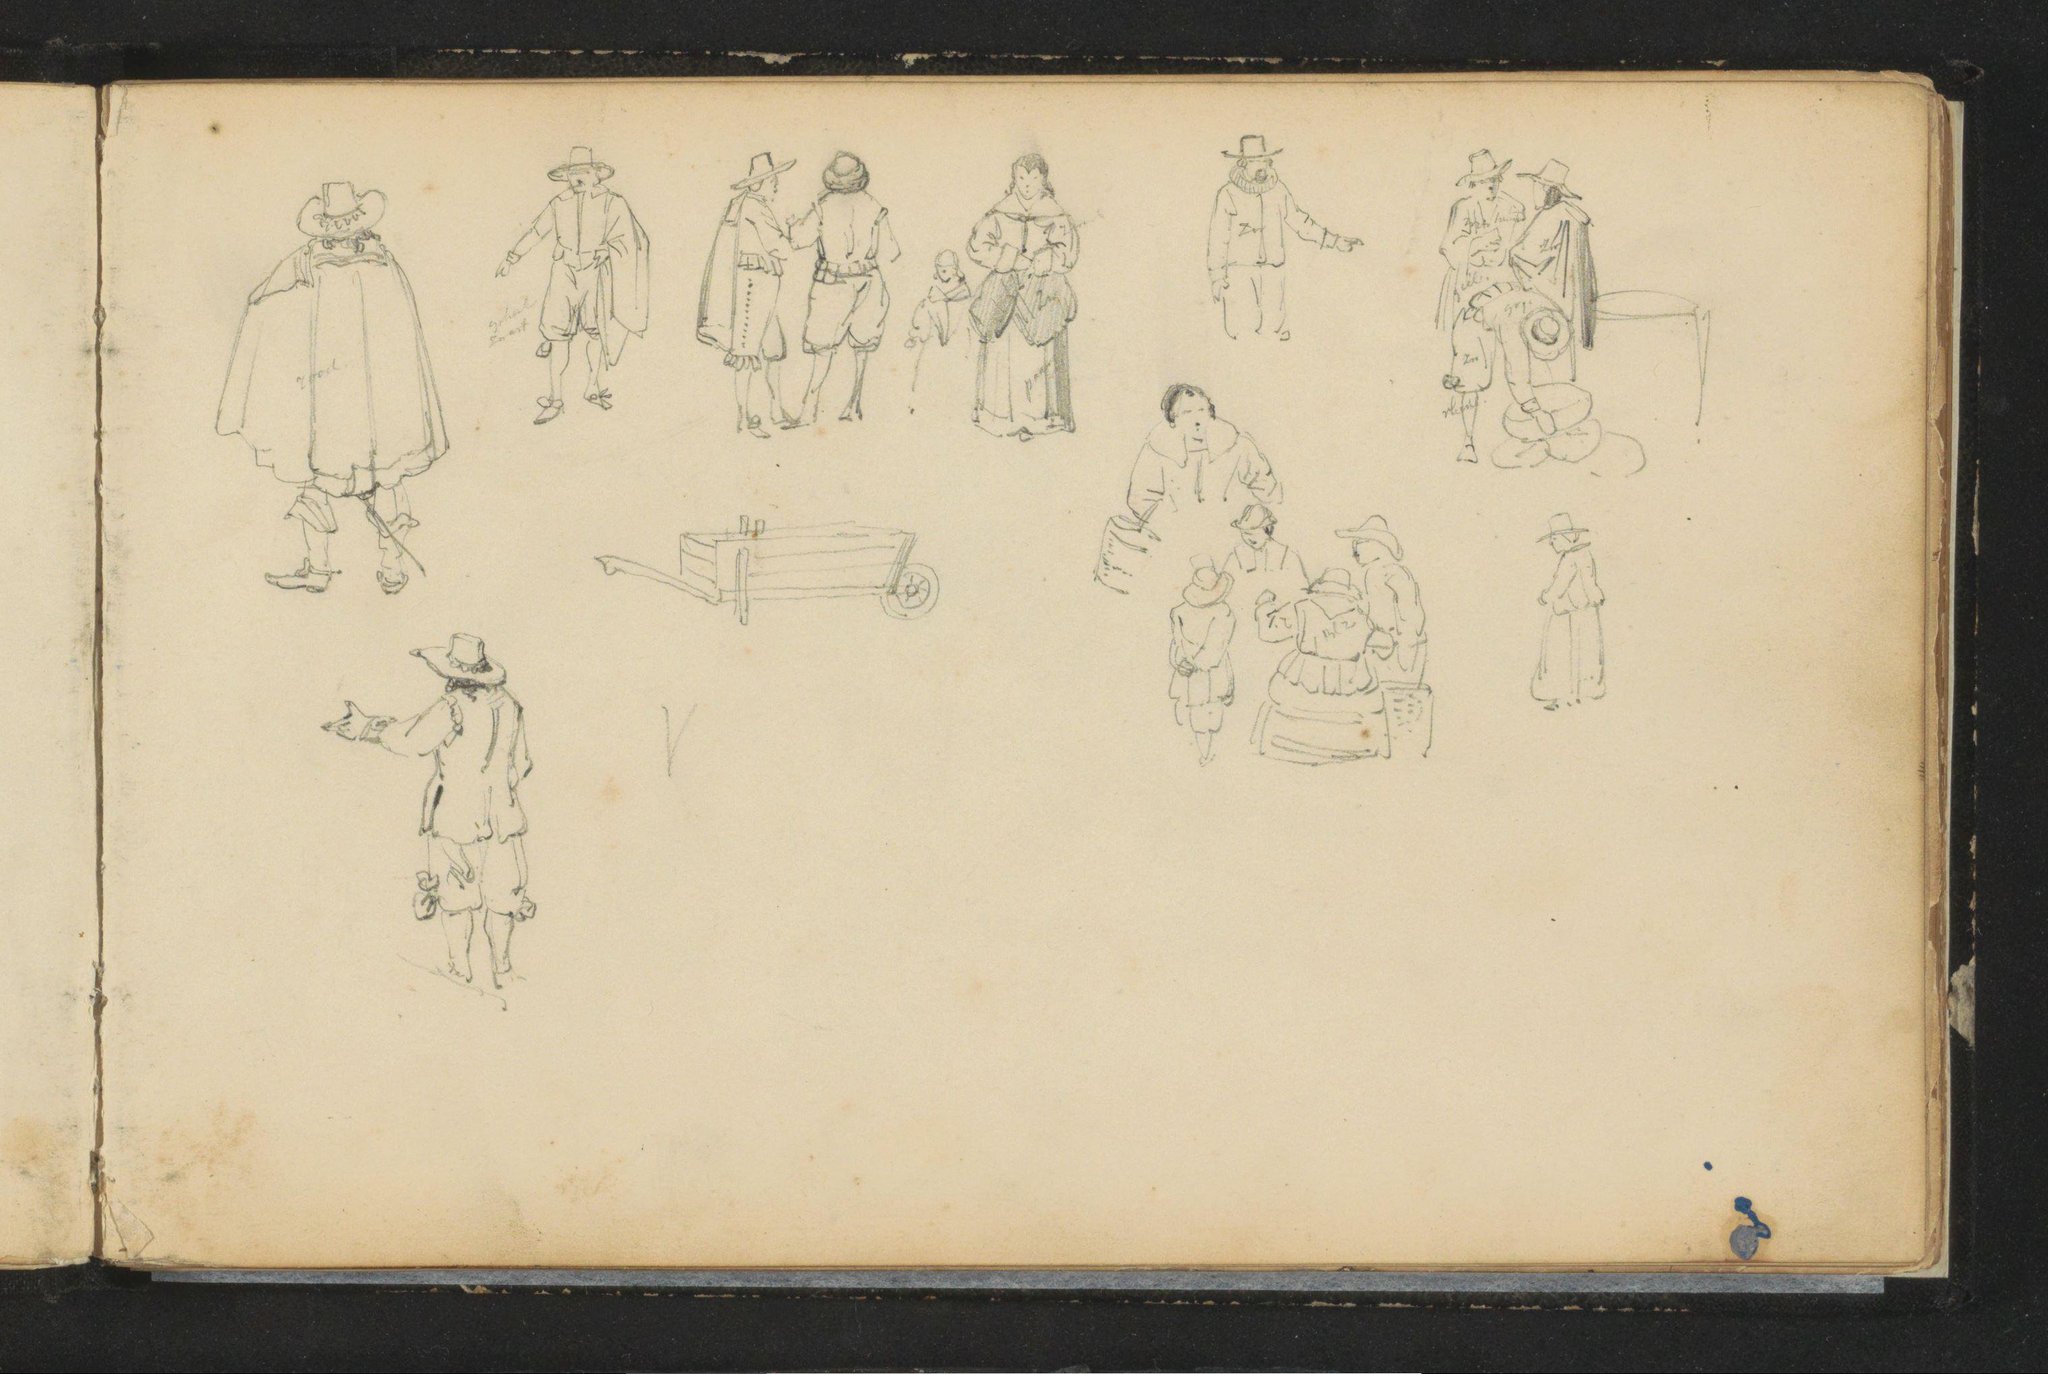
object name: sketchbook leaf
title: Figuren in zeventiende-eeuwse kleding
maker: cornelis springer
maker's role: draughtsman, painter, print maker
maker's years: 1817-1891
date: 1846-1882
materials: paper, pencil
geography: netherlands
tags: adult woman, adult man, clothes, costume (+ women's clothes), clothes, costume (+ men's clothes)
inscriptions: kleurnotitie, handgeschreven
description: Figuren in zeventiende-eeuwse kleding. Blad 10 uit een schetsboek met 91 bladen.